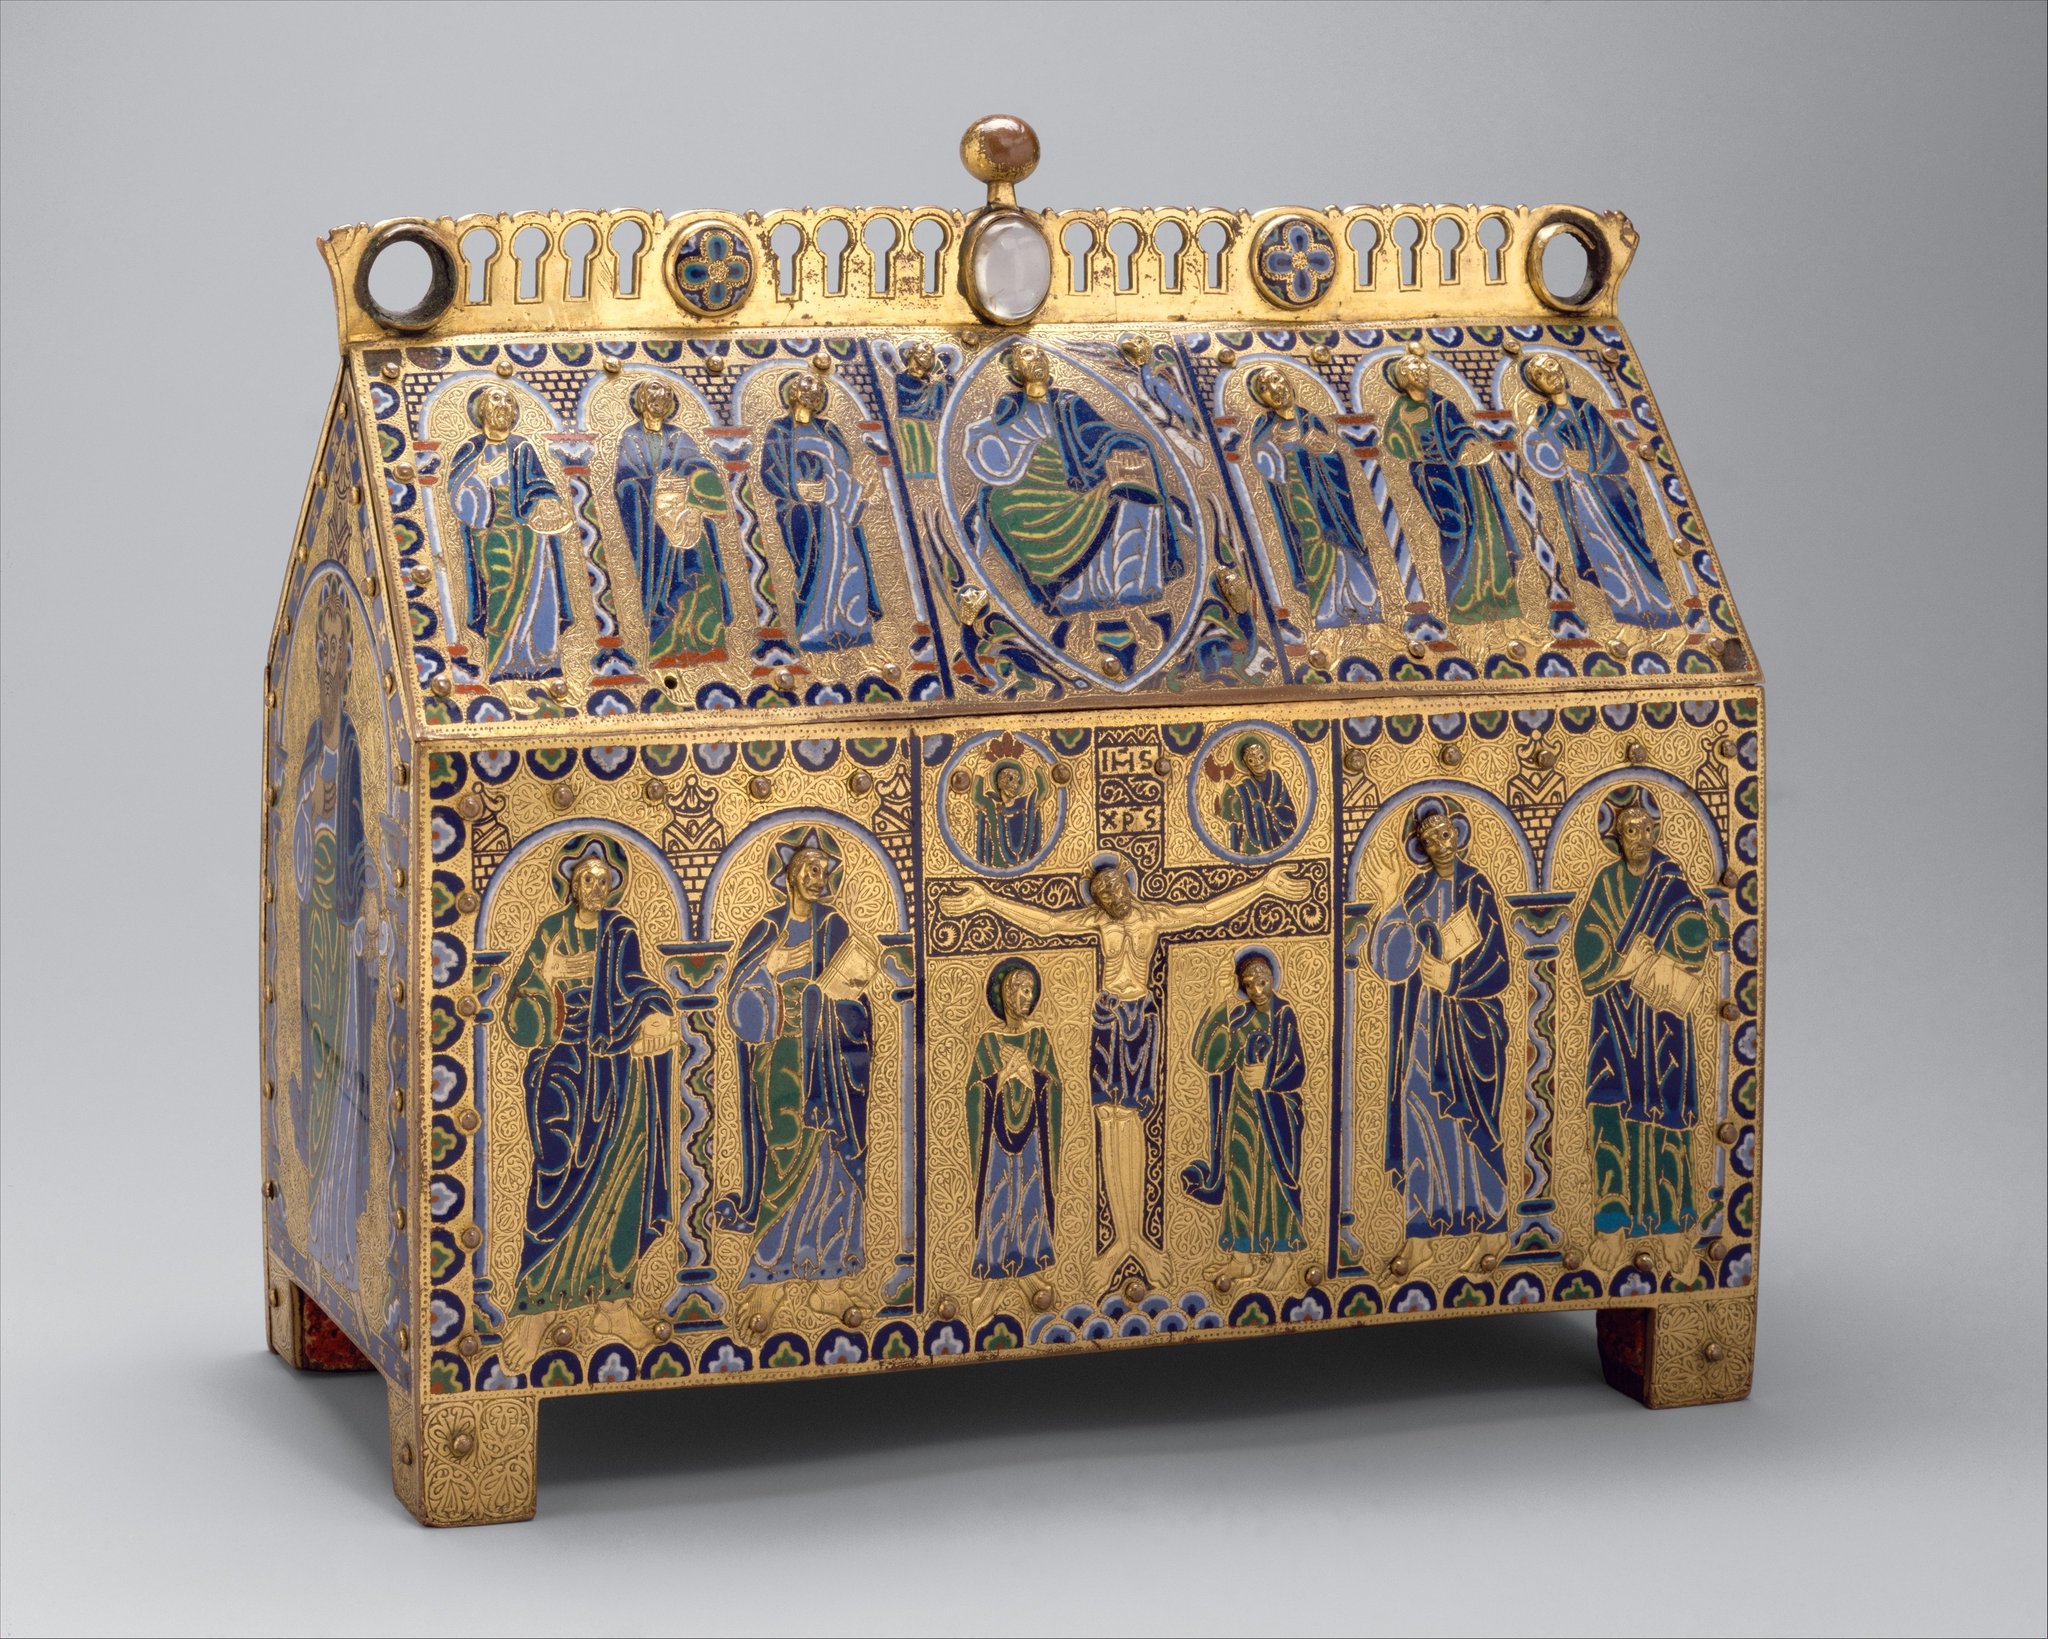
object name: chasse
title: Chasse with the Crucifixion and Christ in Majesty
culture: french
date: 1180-1190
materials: copper, enamel, gilt, wood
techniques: enamel, engraving, painting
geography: france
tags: apostles,christ,saint john the evangelist,virgin mary,crucifixion